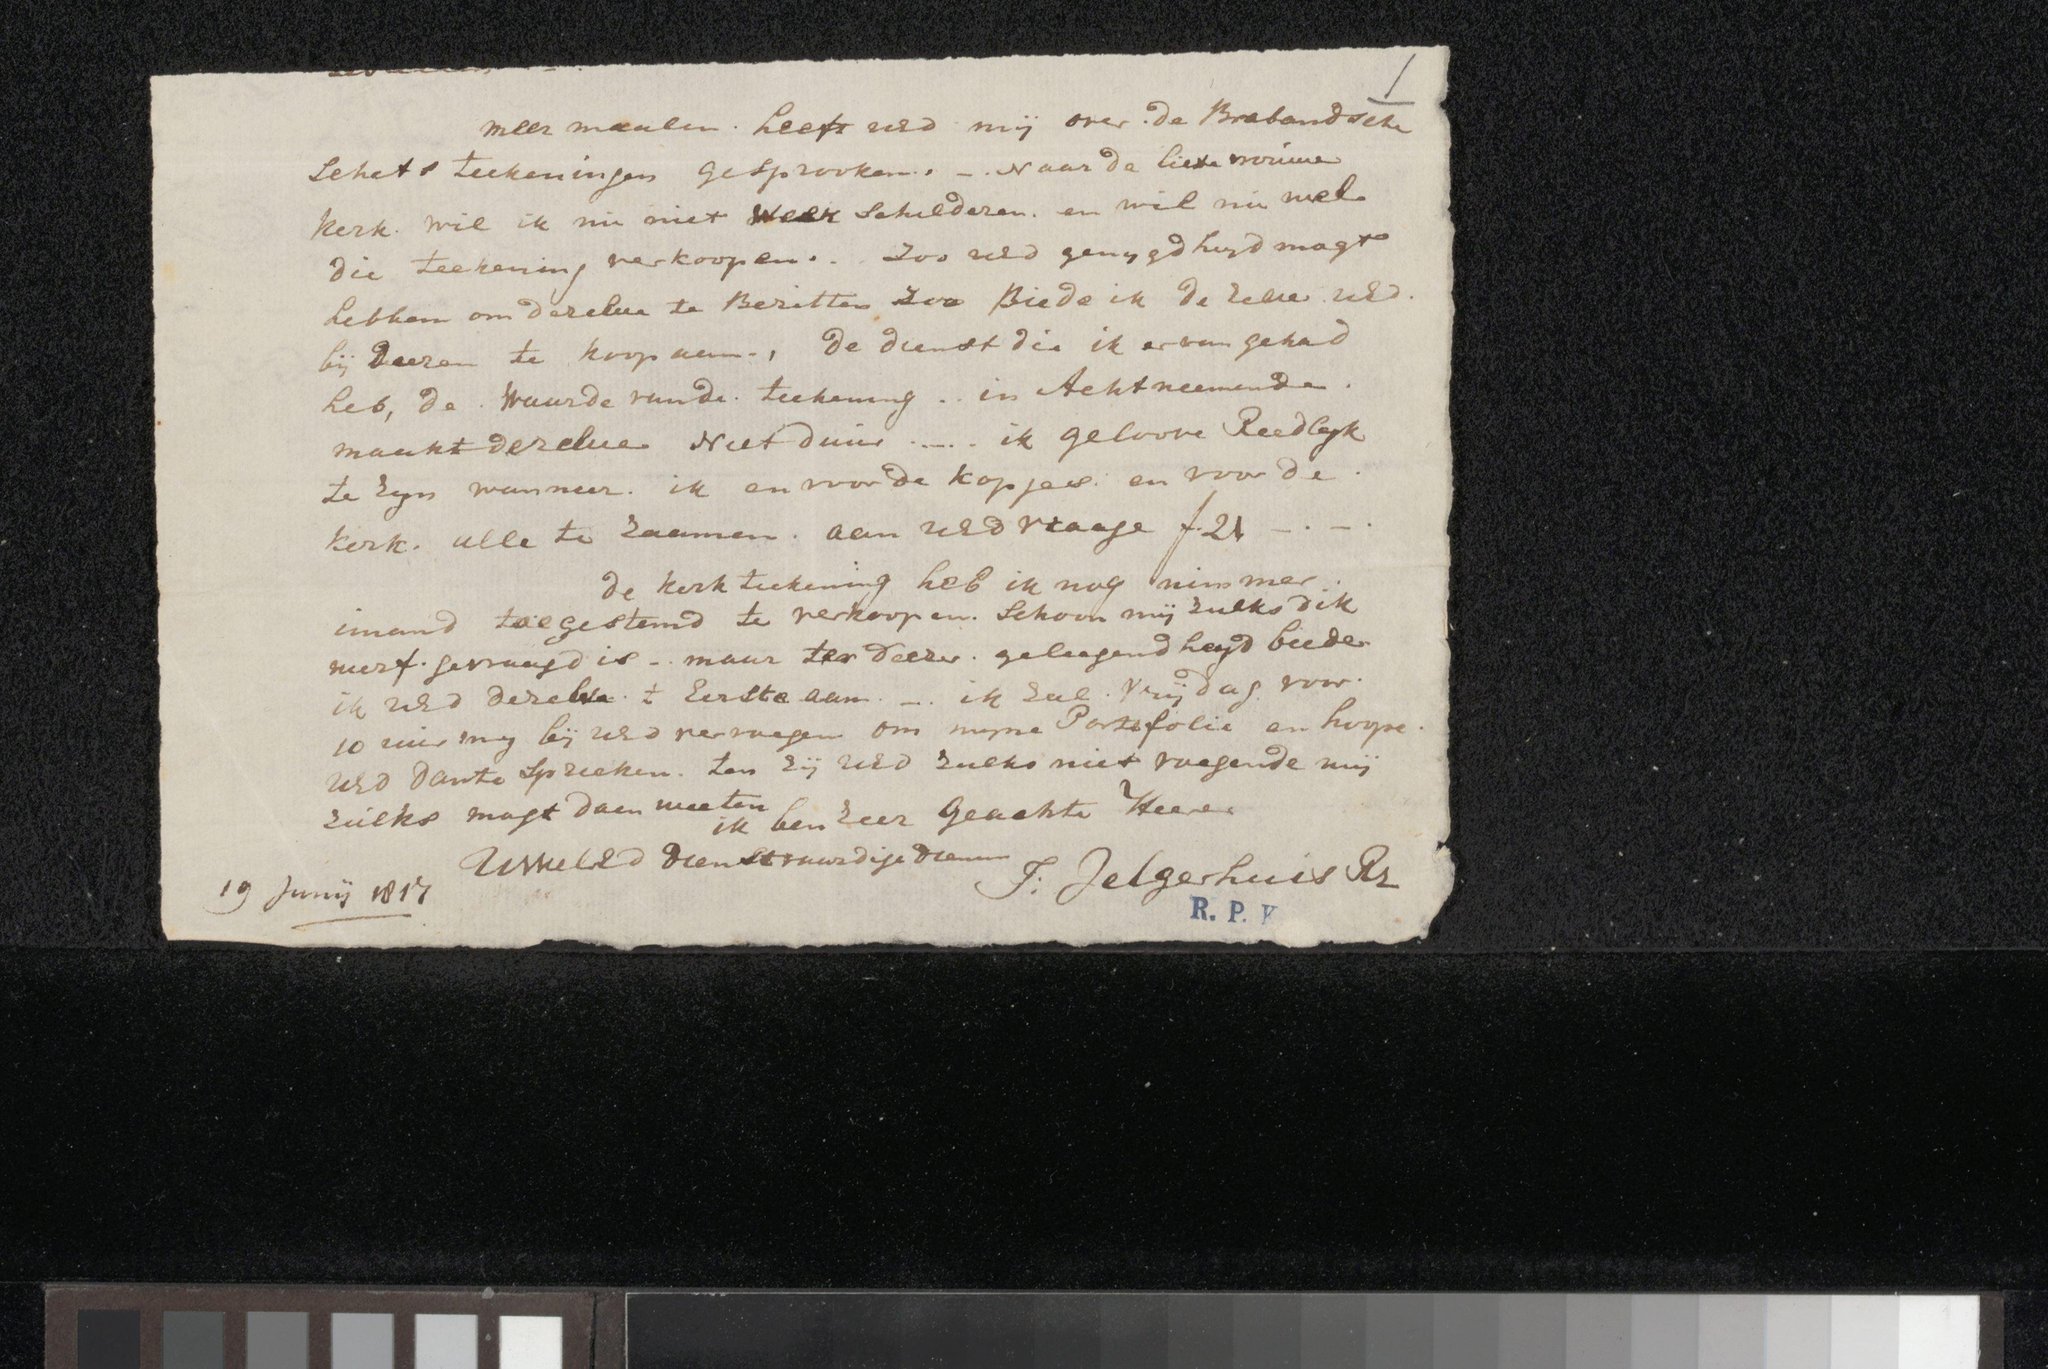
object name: letter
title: Brief aan anoniem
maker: johannes jelgerhuis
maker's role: draughtsman, painter, print maker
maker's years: 1770-1836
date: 1817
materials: ink, paper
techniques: pen, writing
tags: art trade, art shop, drawing, money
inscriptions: collector's mark: Lugt 2233, watermark